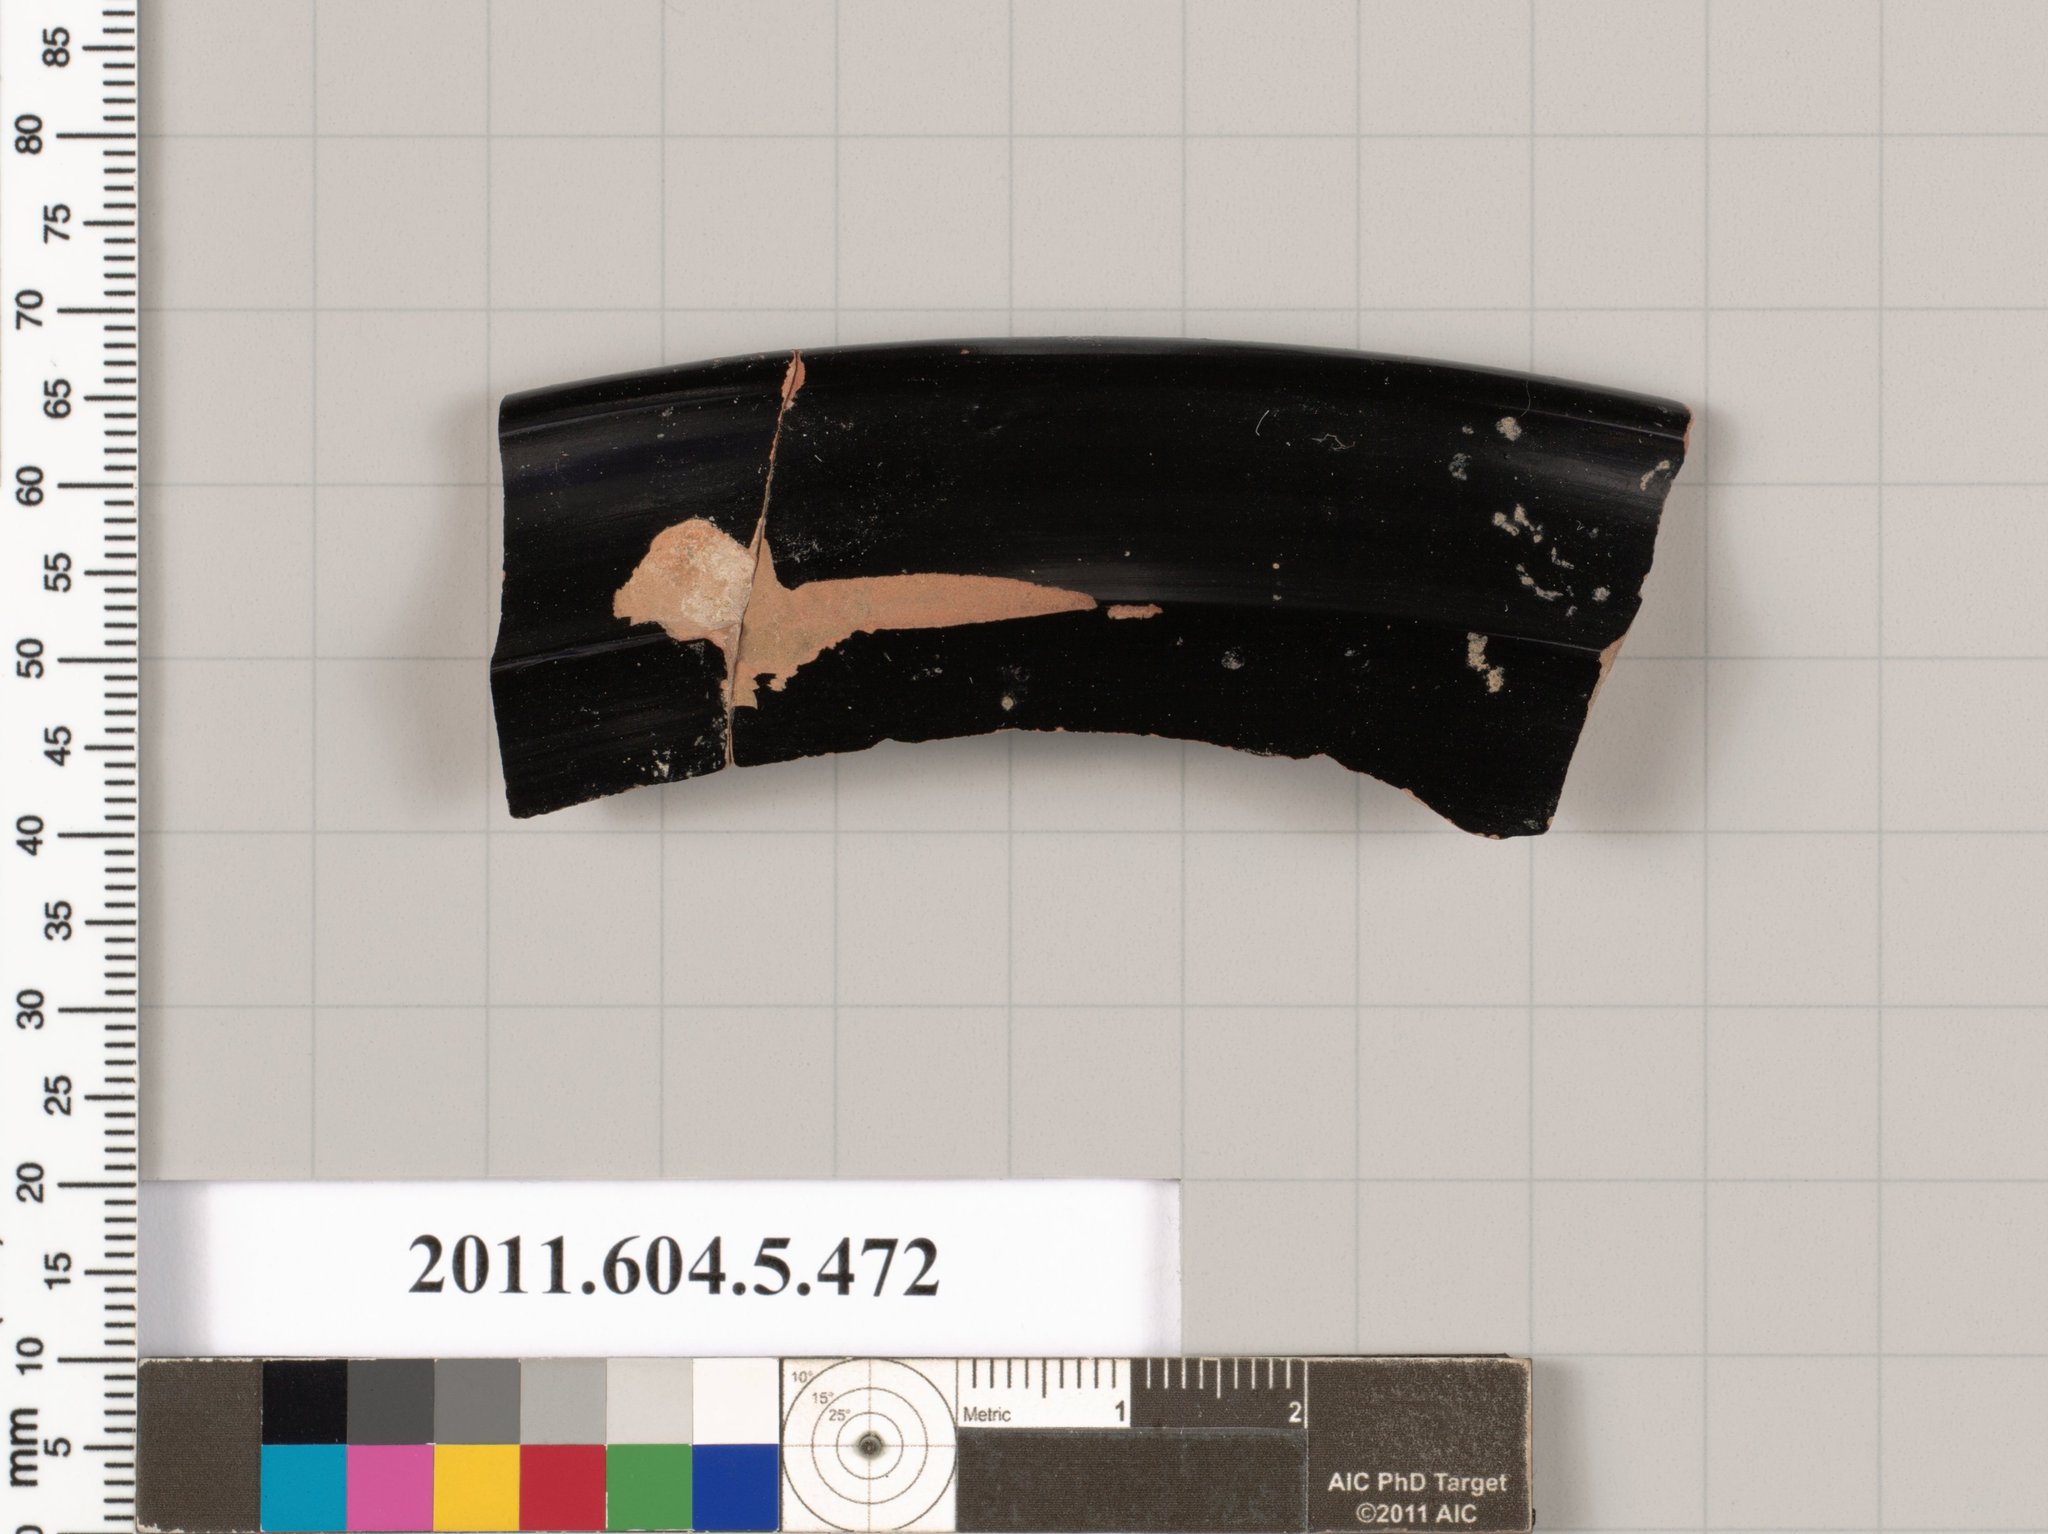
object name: kylix fragment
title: Terracotta rim fragment of a kylix (drinking cup)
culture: greek, attic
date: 600-401 BCE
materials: terracotta